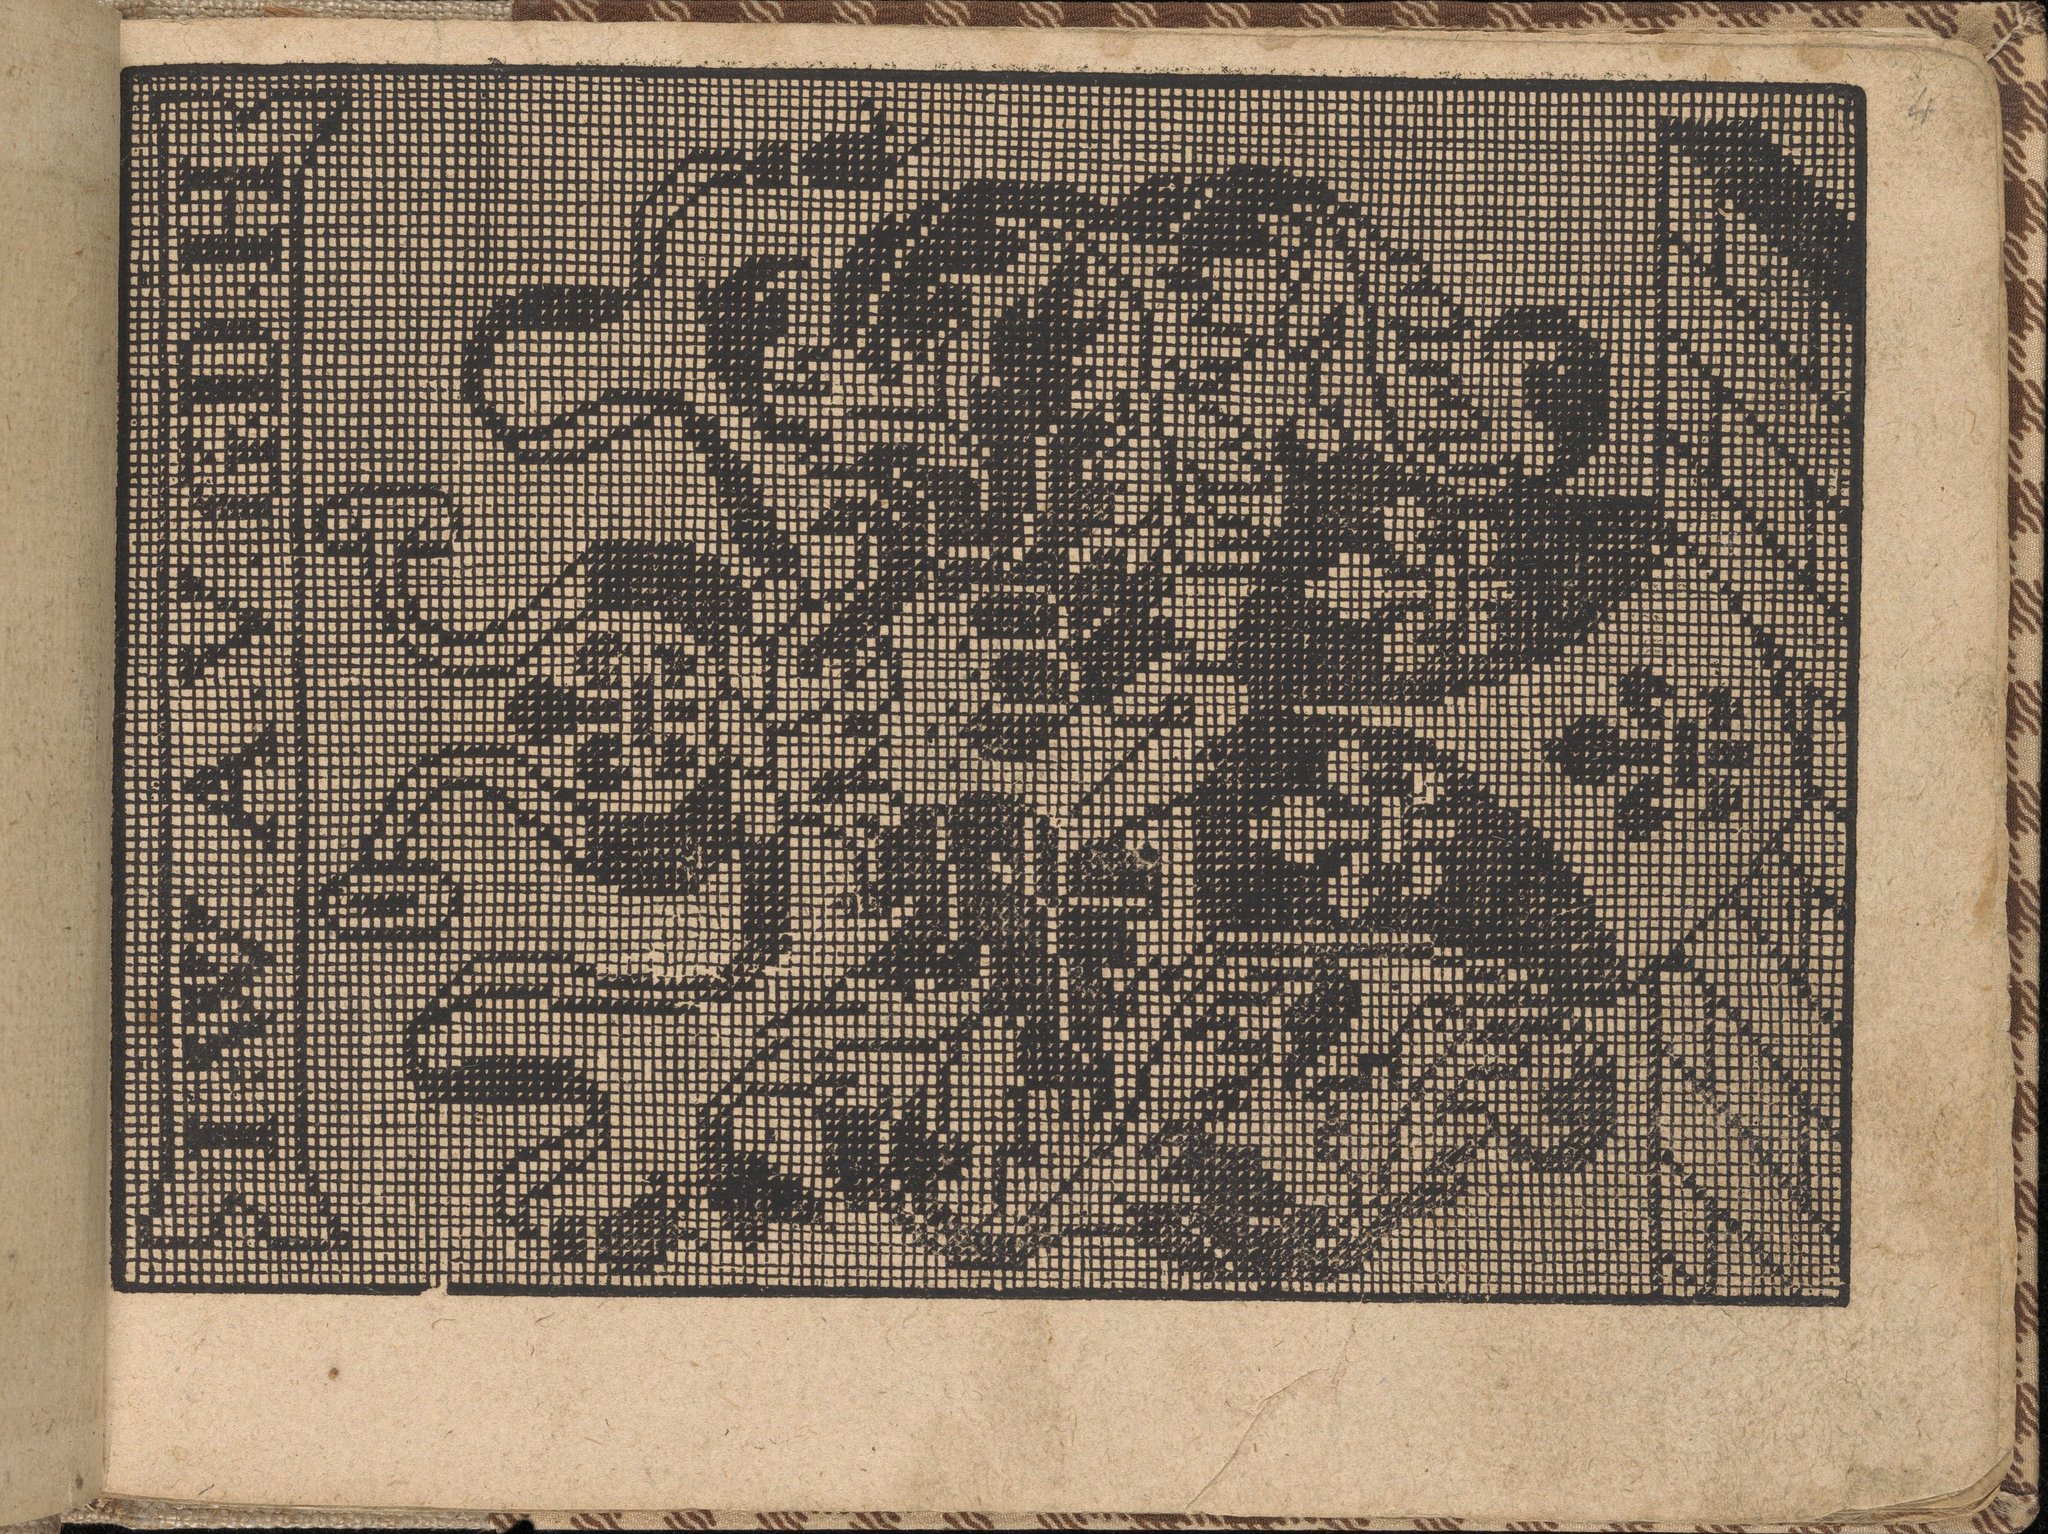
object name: book print ornament architecture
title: New Künstlichs Modelbuch (Page 4 recto)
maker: bernhard jobin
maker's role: publisher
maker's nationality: swiss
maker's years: 1535-1597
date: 1600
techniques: woodcut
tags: coat of arms